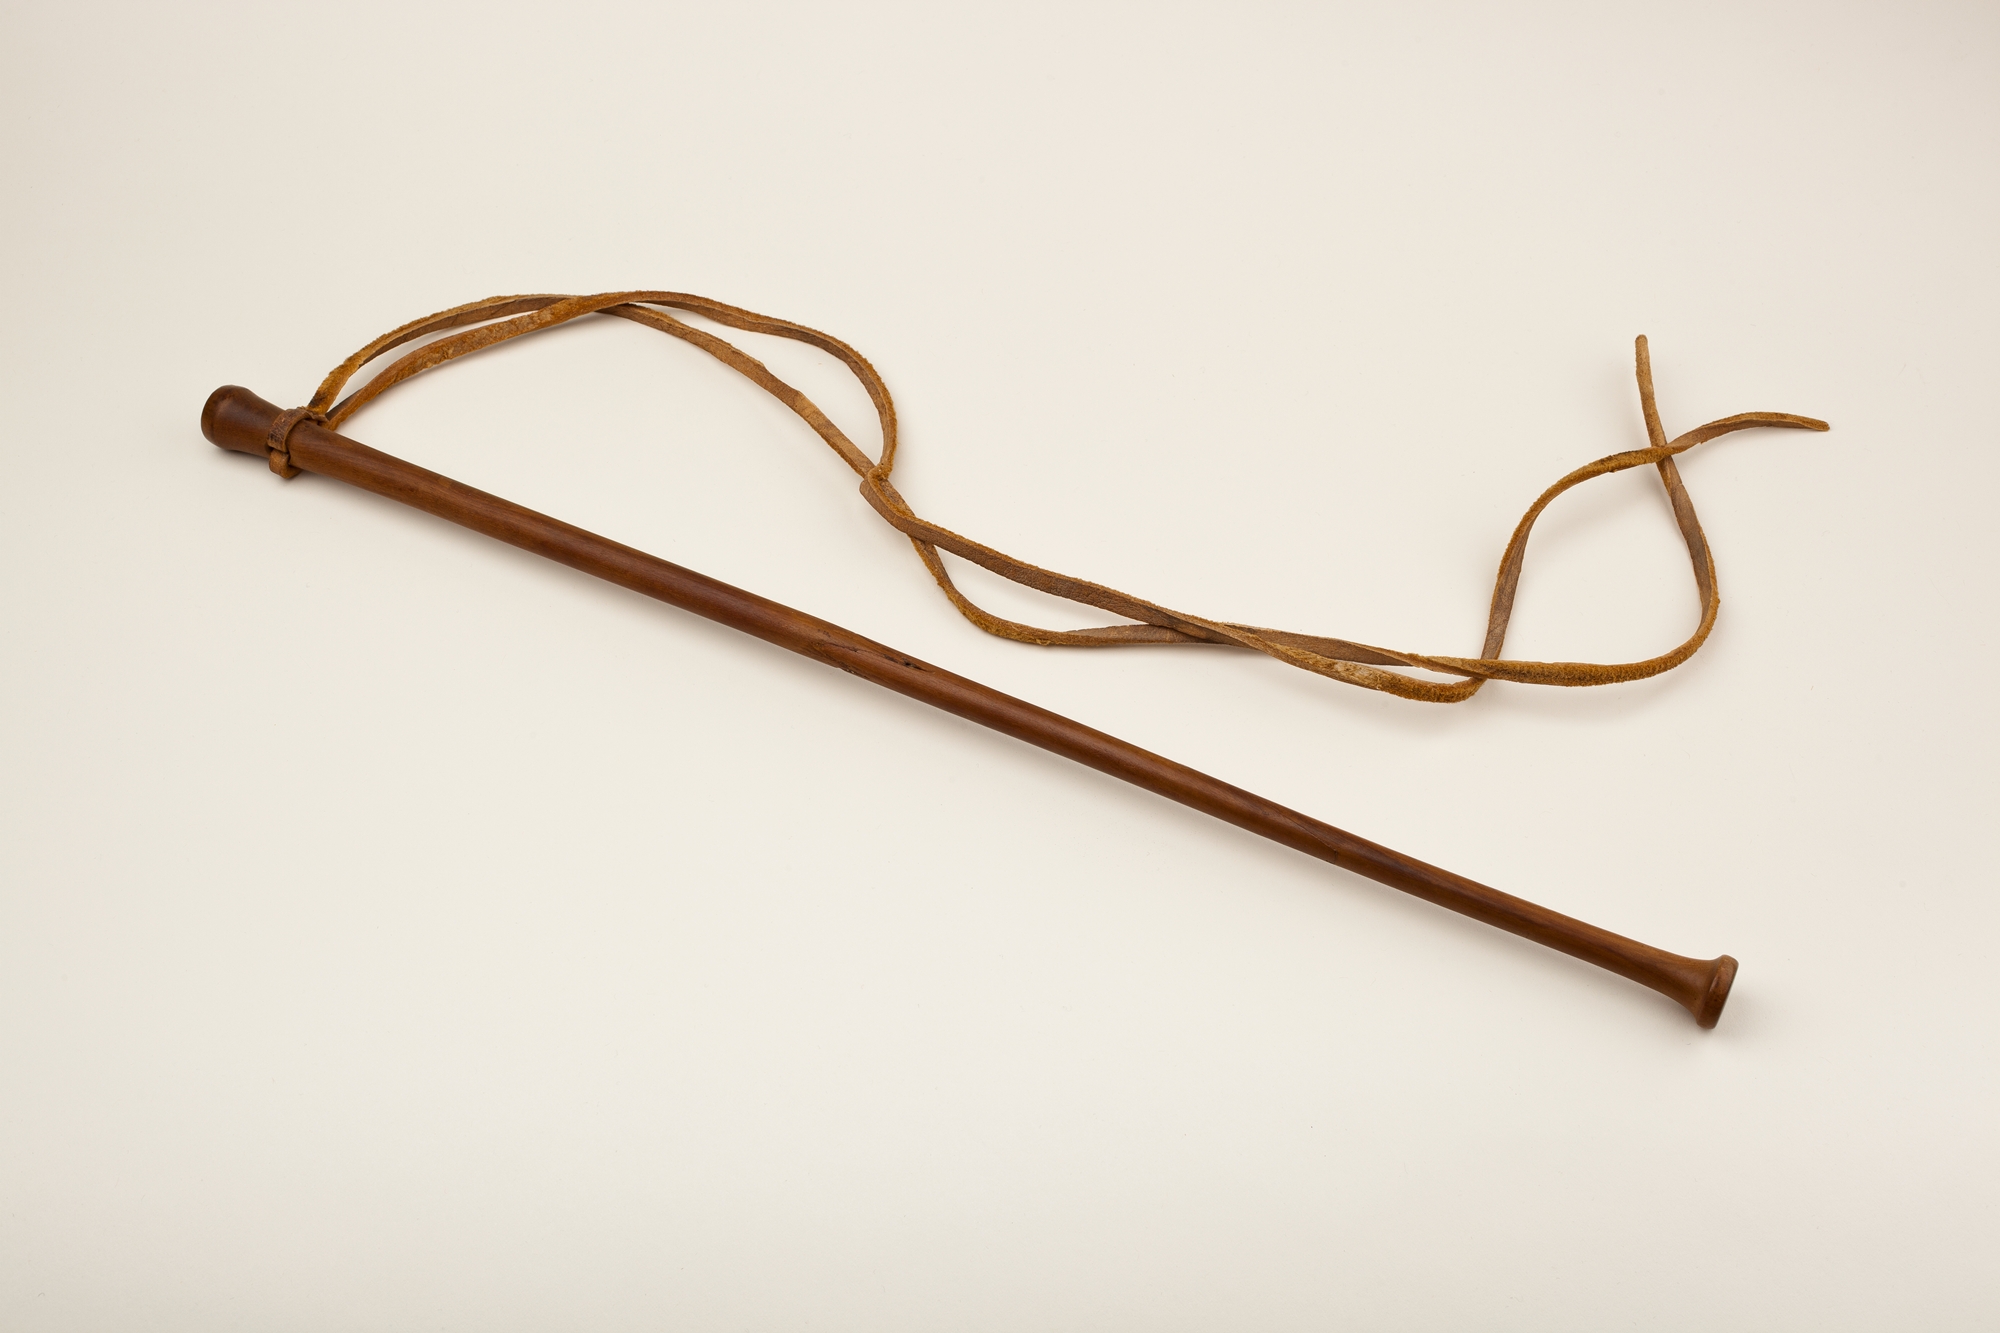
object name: whip, charioteer's, itamun label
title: Charioteer's Whip of Itamun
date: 1070-945 BCE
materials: leather, wood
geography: egypt